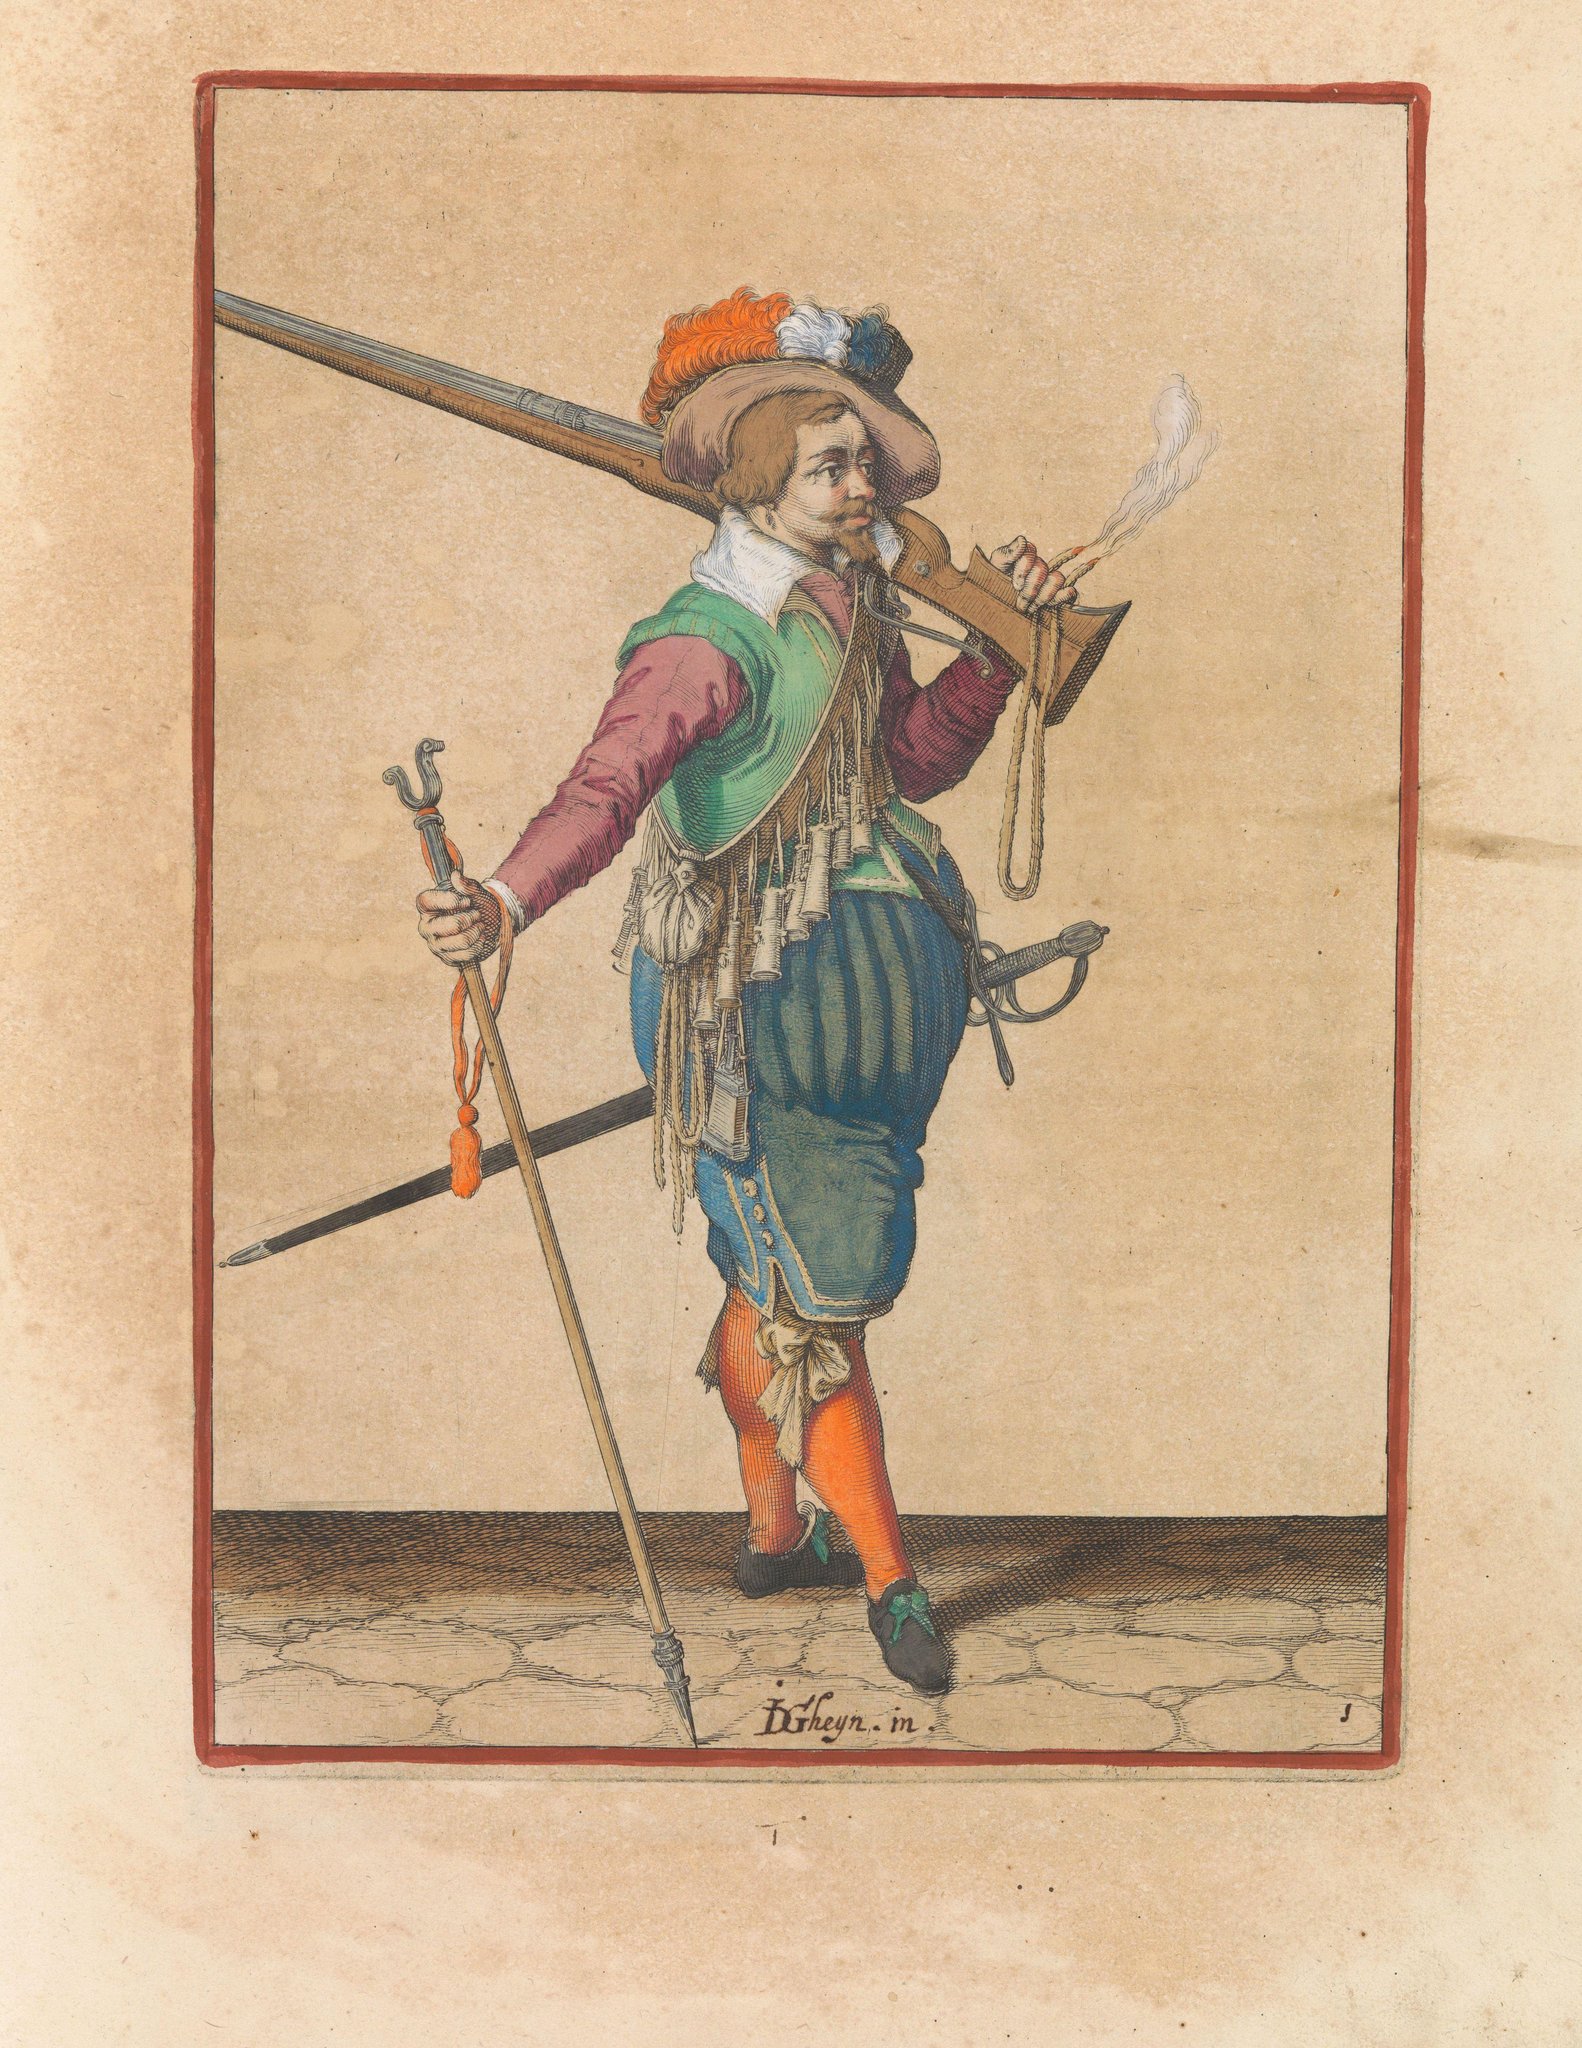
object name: print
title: Corte onderrechtinghe op de figuerliicke afbeeldinghe, soo veel aengaet het recht ghebruyck vant Musquet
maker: jacques de gheyn (ii)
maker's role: painter, print maker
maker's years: 1565-1629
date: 1597-1607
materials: paper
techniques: engraving, hand coloring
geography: the hague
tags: handling of weapons ~ military training, firearms: rifle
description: Een soldaat, ten voeten uit, naar rechts, met een musket (een bepaald type vuurwapen) steunend op zijn linkerschouder. In zijn linkerhand behalve de kolf van het musket ook een brandende lont. In zijn rechterhand een furket (musketvork). Deze prent is onderdeel van de reeks van 43 met de hand genummerde prenten van musketiers in de Wapenhandelinghe.